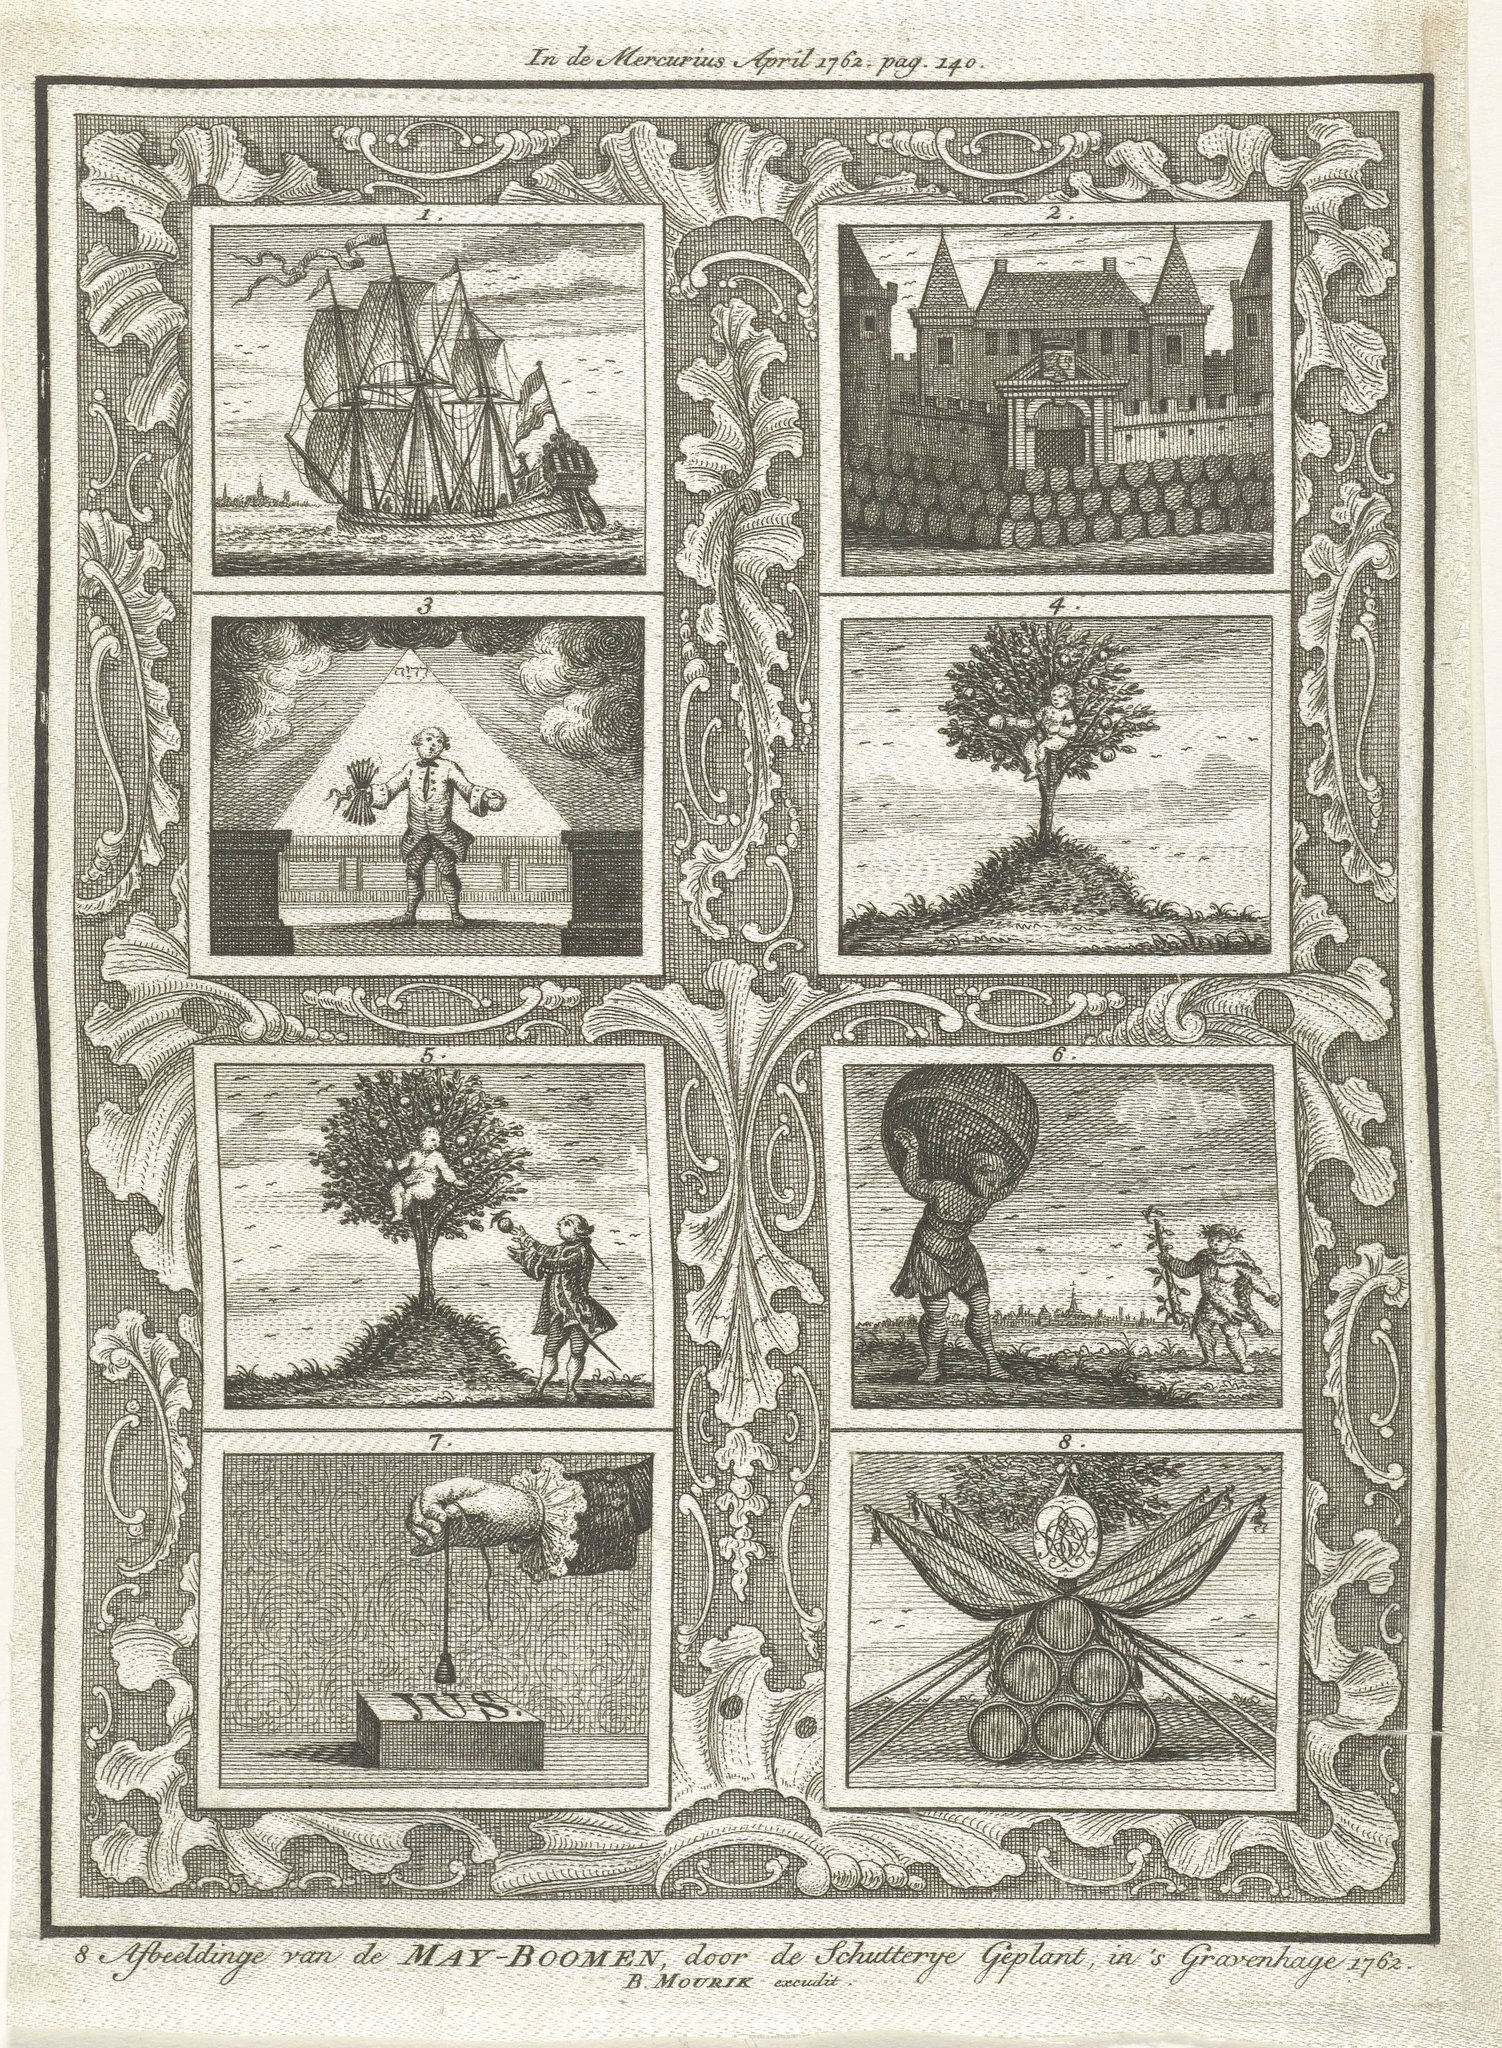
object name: print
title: Meiboom geplant door de Haagse Schutterij, 1762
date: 1762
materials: textile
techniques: engraving, etching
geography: northern netherlands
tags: maypole, the hague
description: De acht allegorische voorstellingen of emblemen van de meiboom geplant door de Schutterij van Den Haag in het jaar 1762.